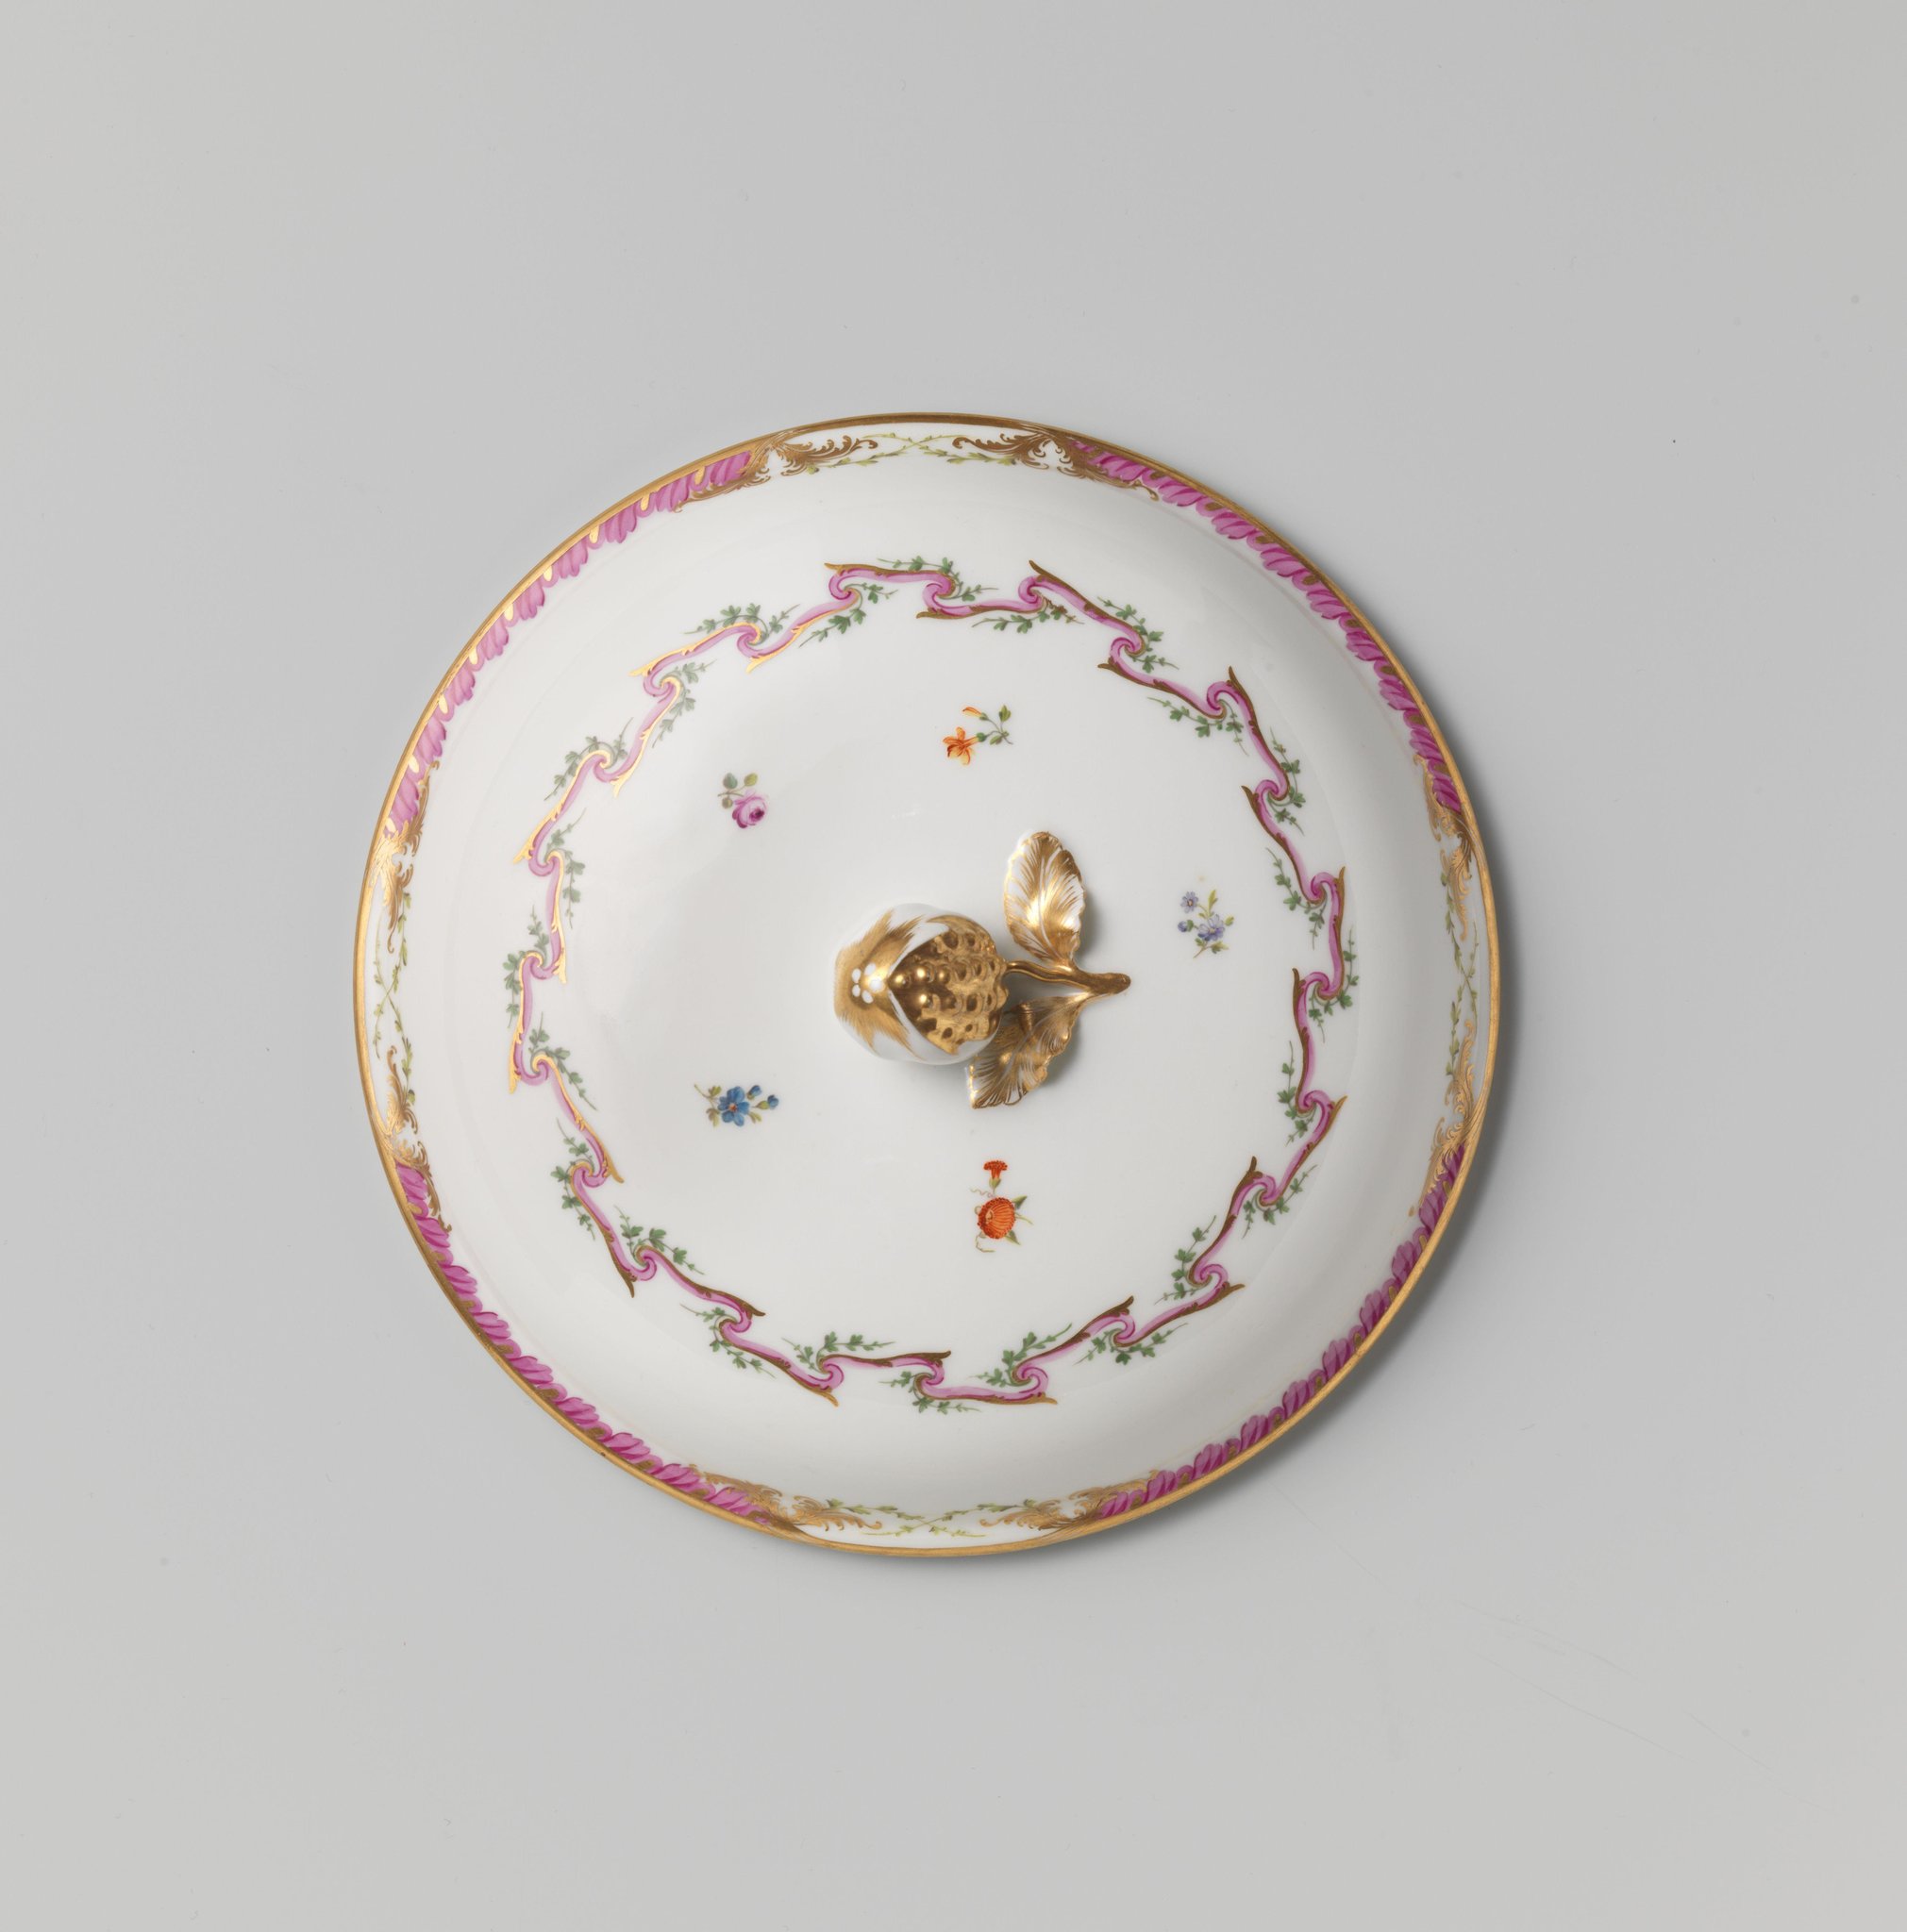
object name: lid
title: Deksel van bak of schaal, rond, en houten steel, behorend bij een servies met geslingerd lintmotief met bladertakken, bloemboeketten en gestrooide bloemtakken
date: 1780-1820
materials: porcelain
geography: amsterdam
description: Deksel van bak of schaal, rond, met deksel, behorend bij een servies van porselein, versierd met een geslingerd lintmotief in paars en goud met groene bladertakken, bloemboeketten en gestrooide bloemtakken. Randen lichtgegolfd met decoratie in goud met paars bladmotief waartussen groen gekruist bladmotief. Dekselknop in de vorm van een vrucht met steel en bladeren in goud. Gemerkt: M.O.L. en Amstel.